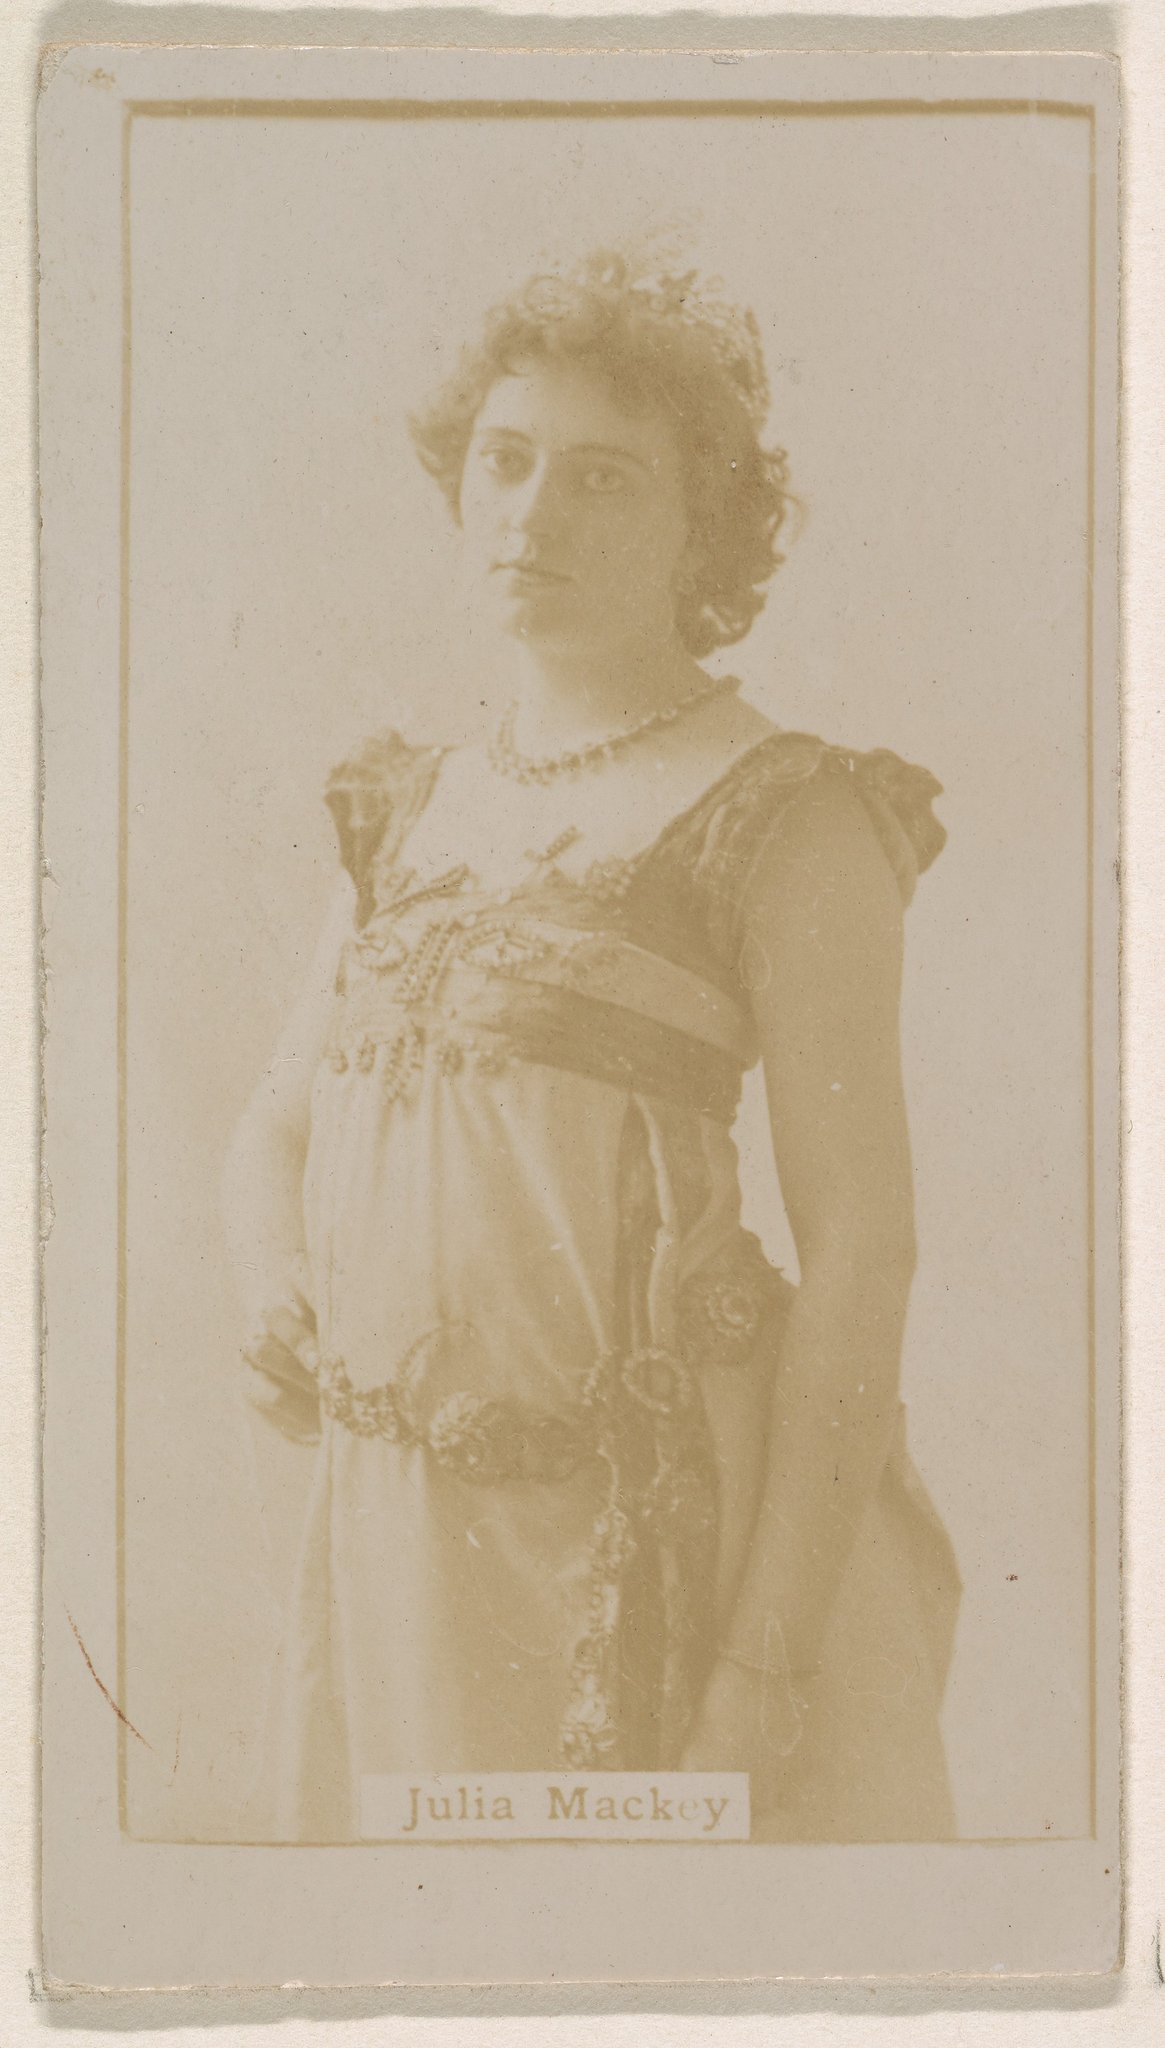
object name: photograph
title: Julia Mackey, from the Actresses series (N245) issued by Kinney Brothers to promote Sweet Caporal Cigarettes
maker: kinney brothers tobacco company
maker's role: publisher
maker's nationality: american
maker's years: 1869-2011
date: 1890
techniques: albumen silver print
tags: portraits,women,actresses